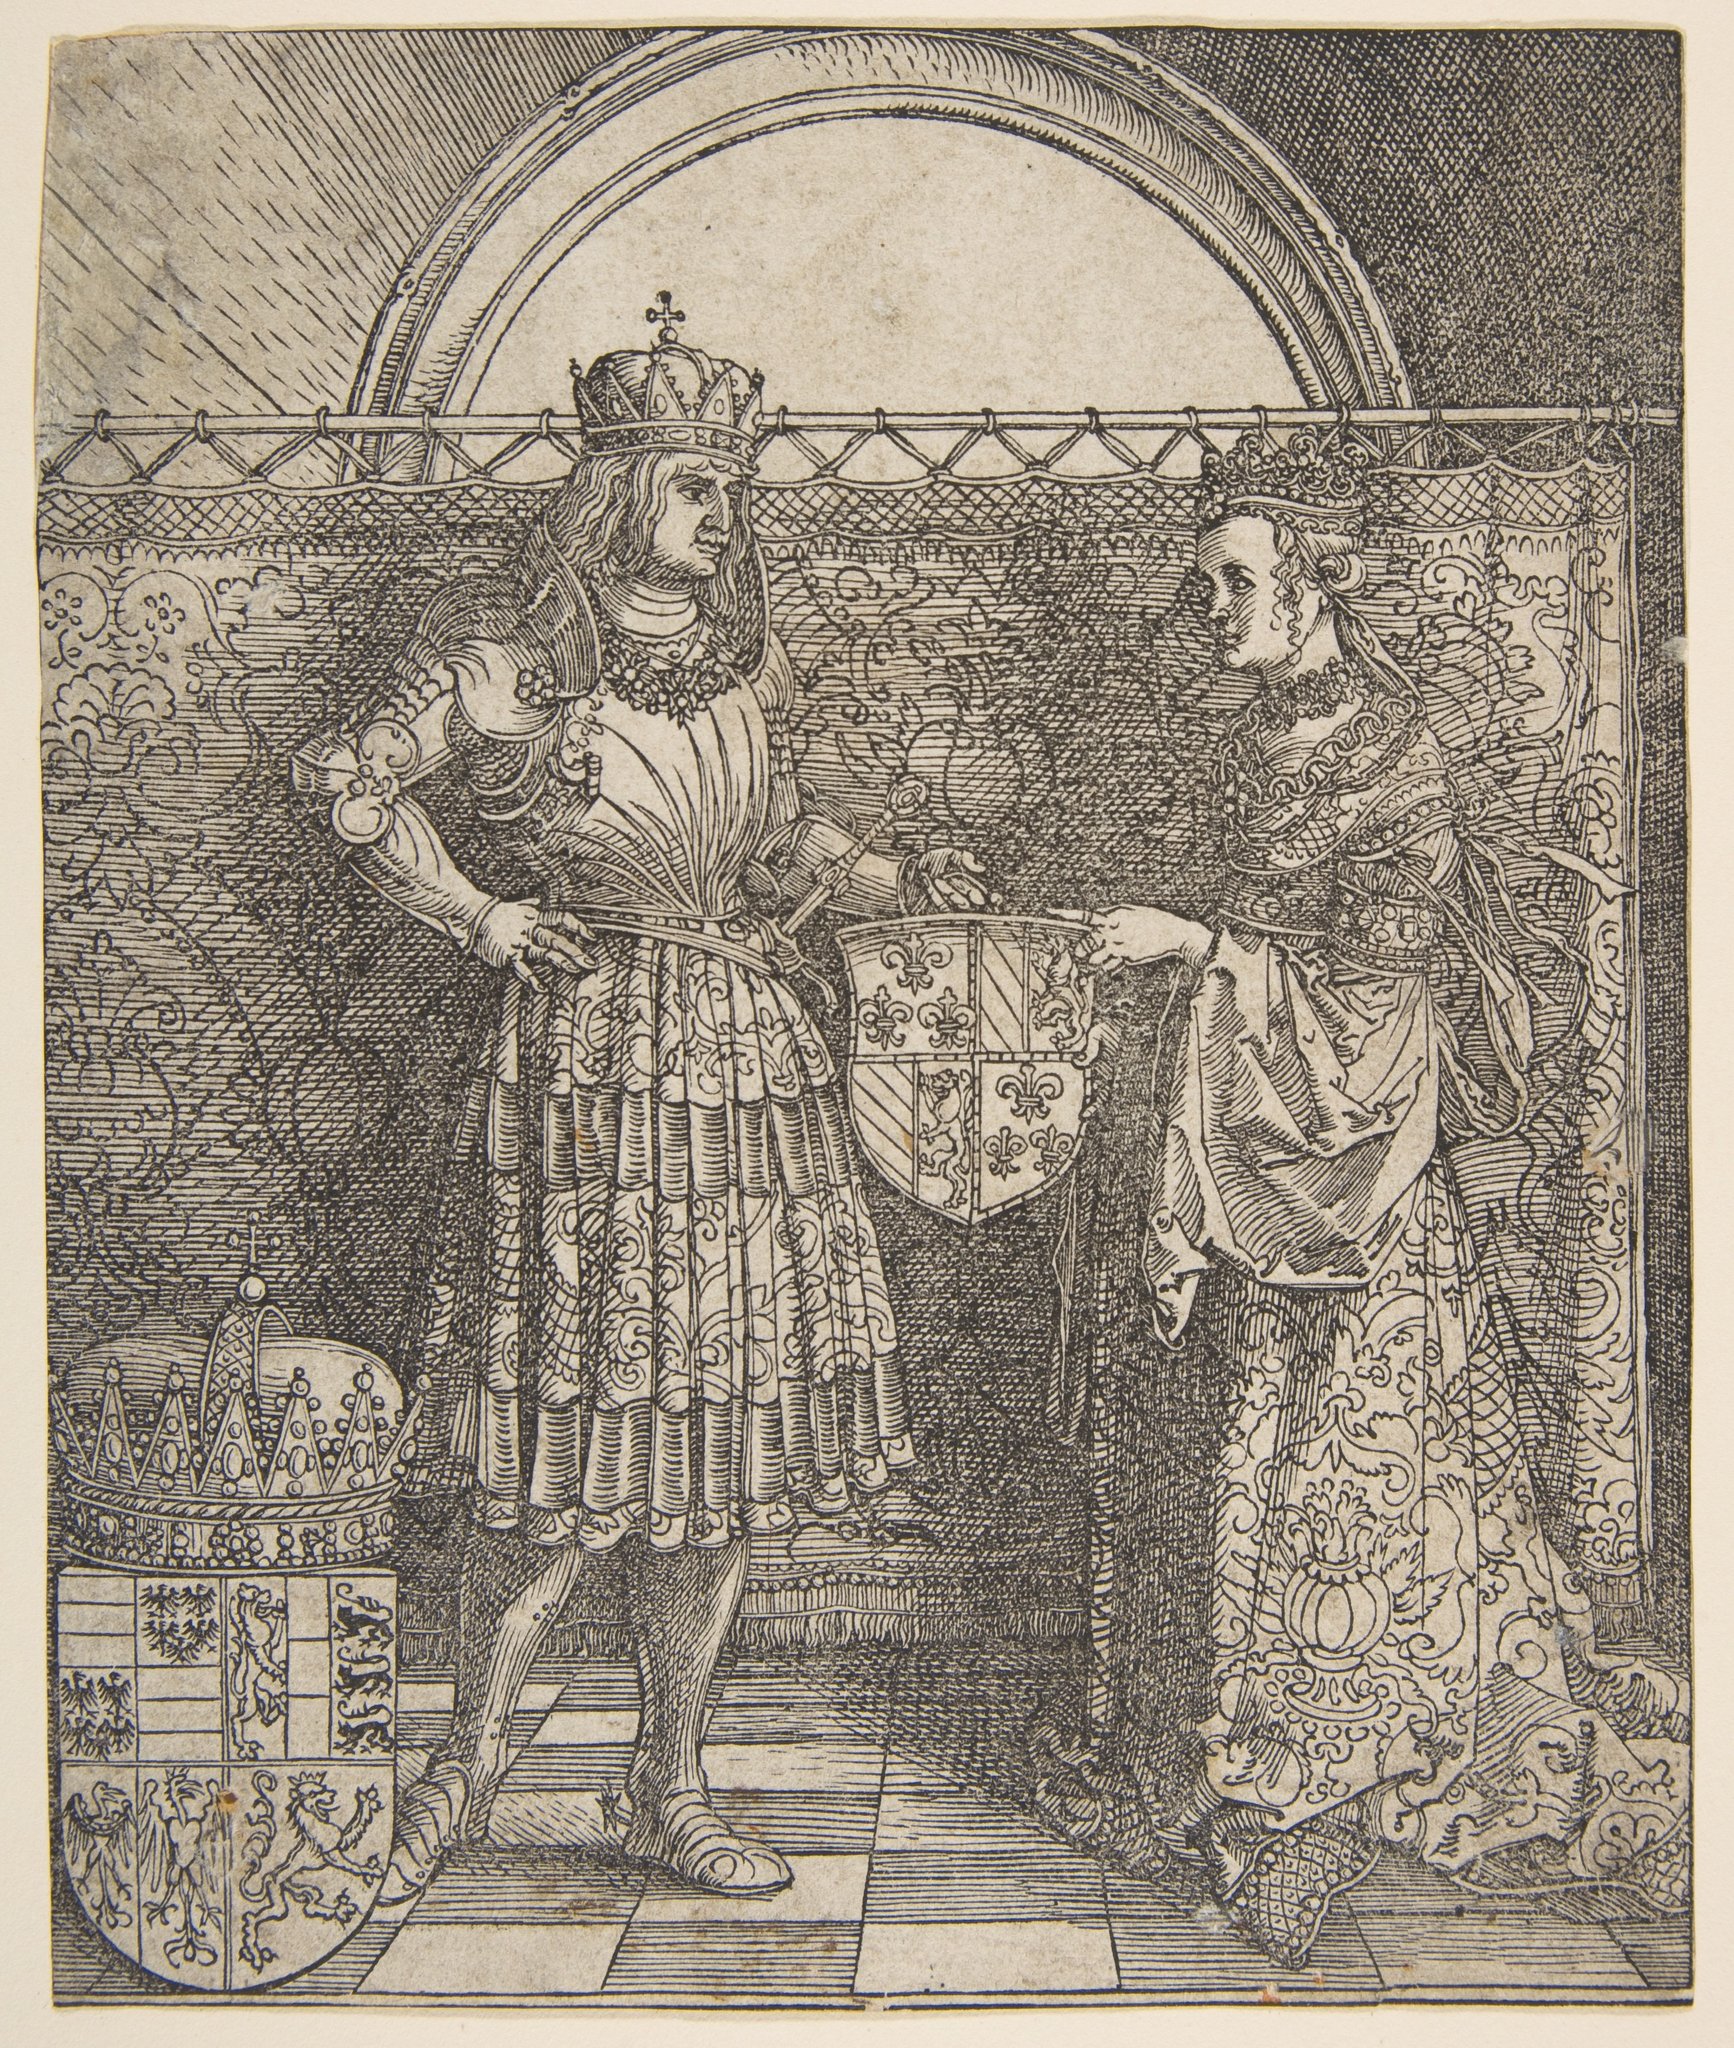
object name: print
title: The Betrothal of Mary of Burgundy from the Triumphal Arch of Emperor Maximilian I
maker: albrecht dürer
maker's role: artist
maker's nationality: german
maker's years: 1471-1528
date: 1515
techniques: woodcut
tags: kings,queens,coat of arms